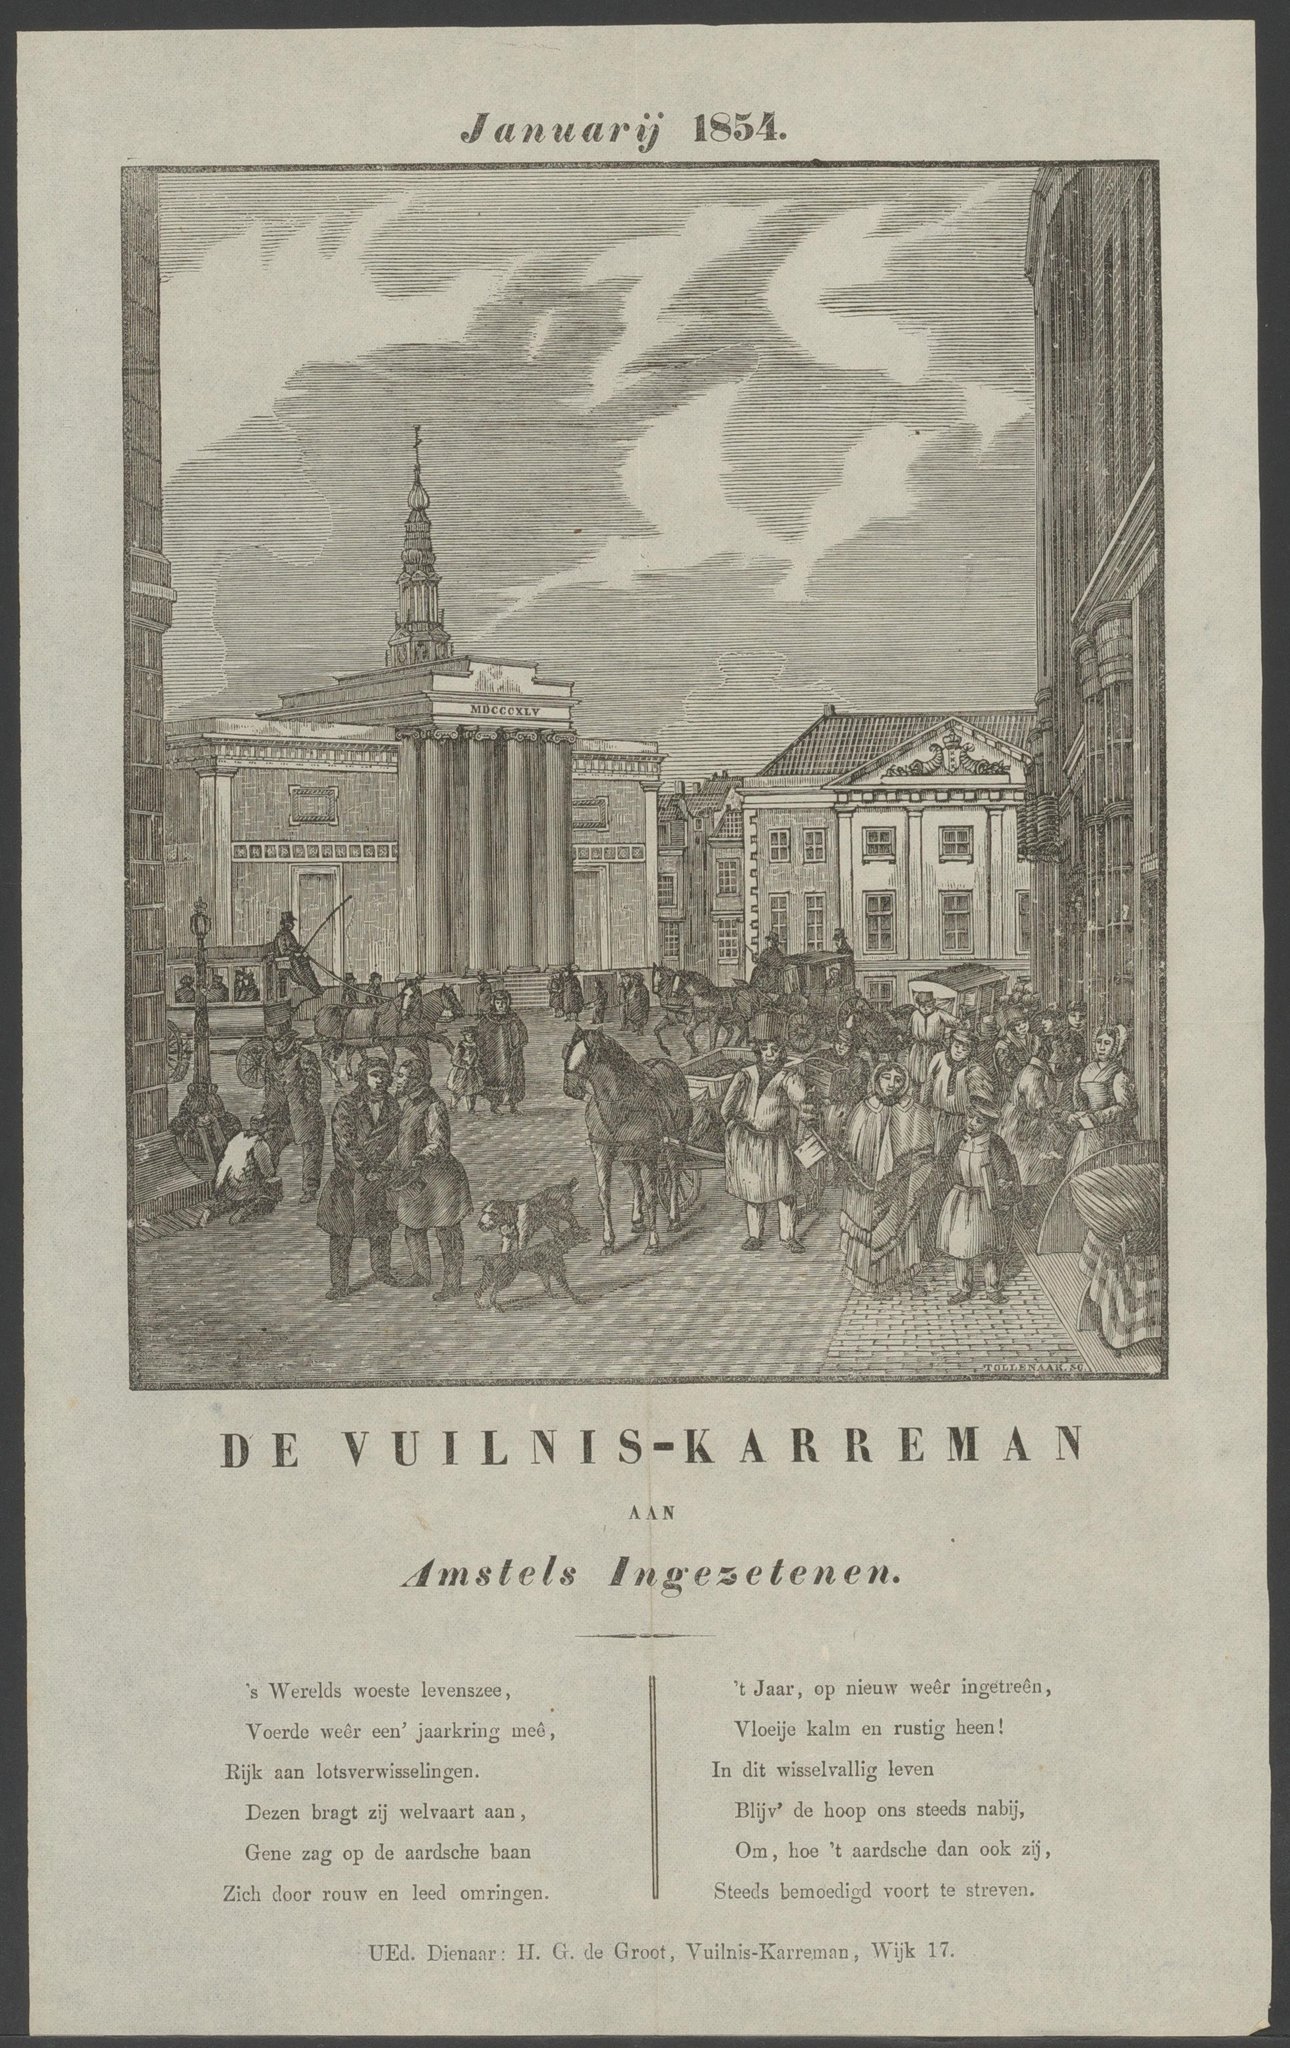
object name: print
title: Nieuwjaarswens van de vuilnismannen van Amsterdam voor het jaar 1854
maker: dirk wijbrand tollenaar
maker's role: print maker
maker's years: 1808-1858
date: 1850-1851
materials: paper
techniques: letterpress printing, engraving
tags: street, garbage collection, amsterdam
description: Nieuwjaarswens van de Amsterdamse vuilnismannen voor het jaar 1853. Gezicht op de Dam met de Beurs van Zocher en het Commandantshuis te Amsterdam. Tussen het publiek de vuilnismannen met hun kar. Met gedicht in twee kolommen. Van de vuilniskarman in de wijk no. 17: H.G. de Groot. Onderwerpsrubrieken binnen de Atlas Zeden en Gewoonten: Zeden en gewoonten in engeren zin, Volksleven, Volksbladen, Nieuwjaars- en Kerstwenschen, Amsterdam.